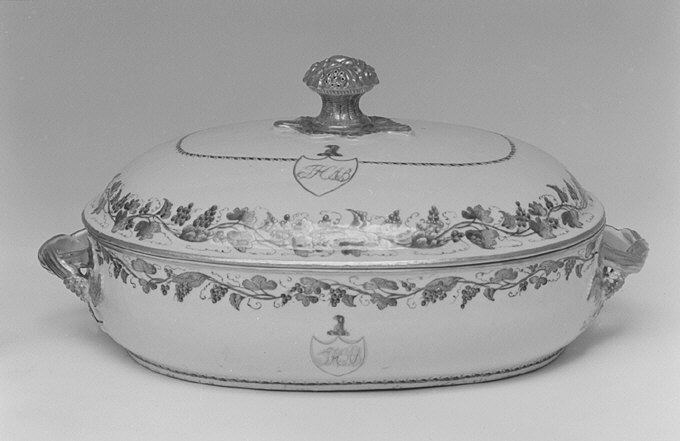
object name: vegetable dish with cover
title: Vegetable dish with cover (part of a service)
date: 1790-1800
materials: hard paste porcelain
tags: grapes,insignia